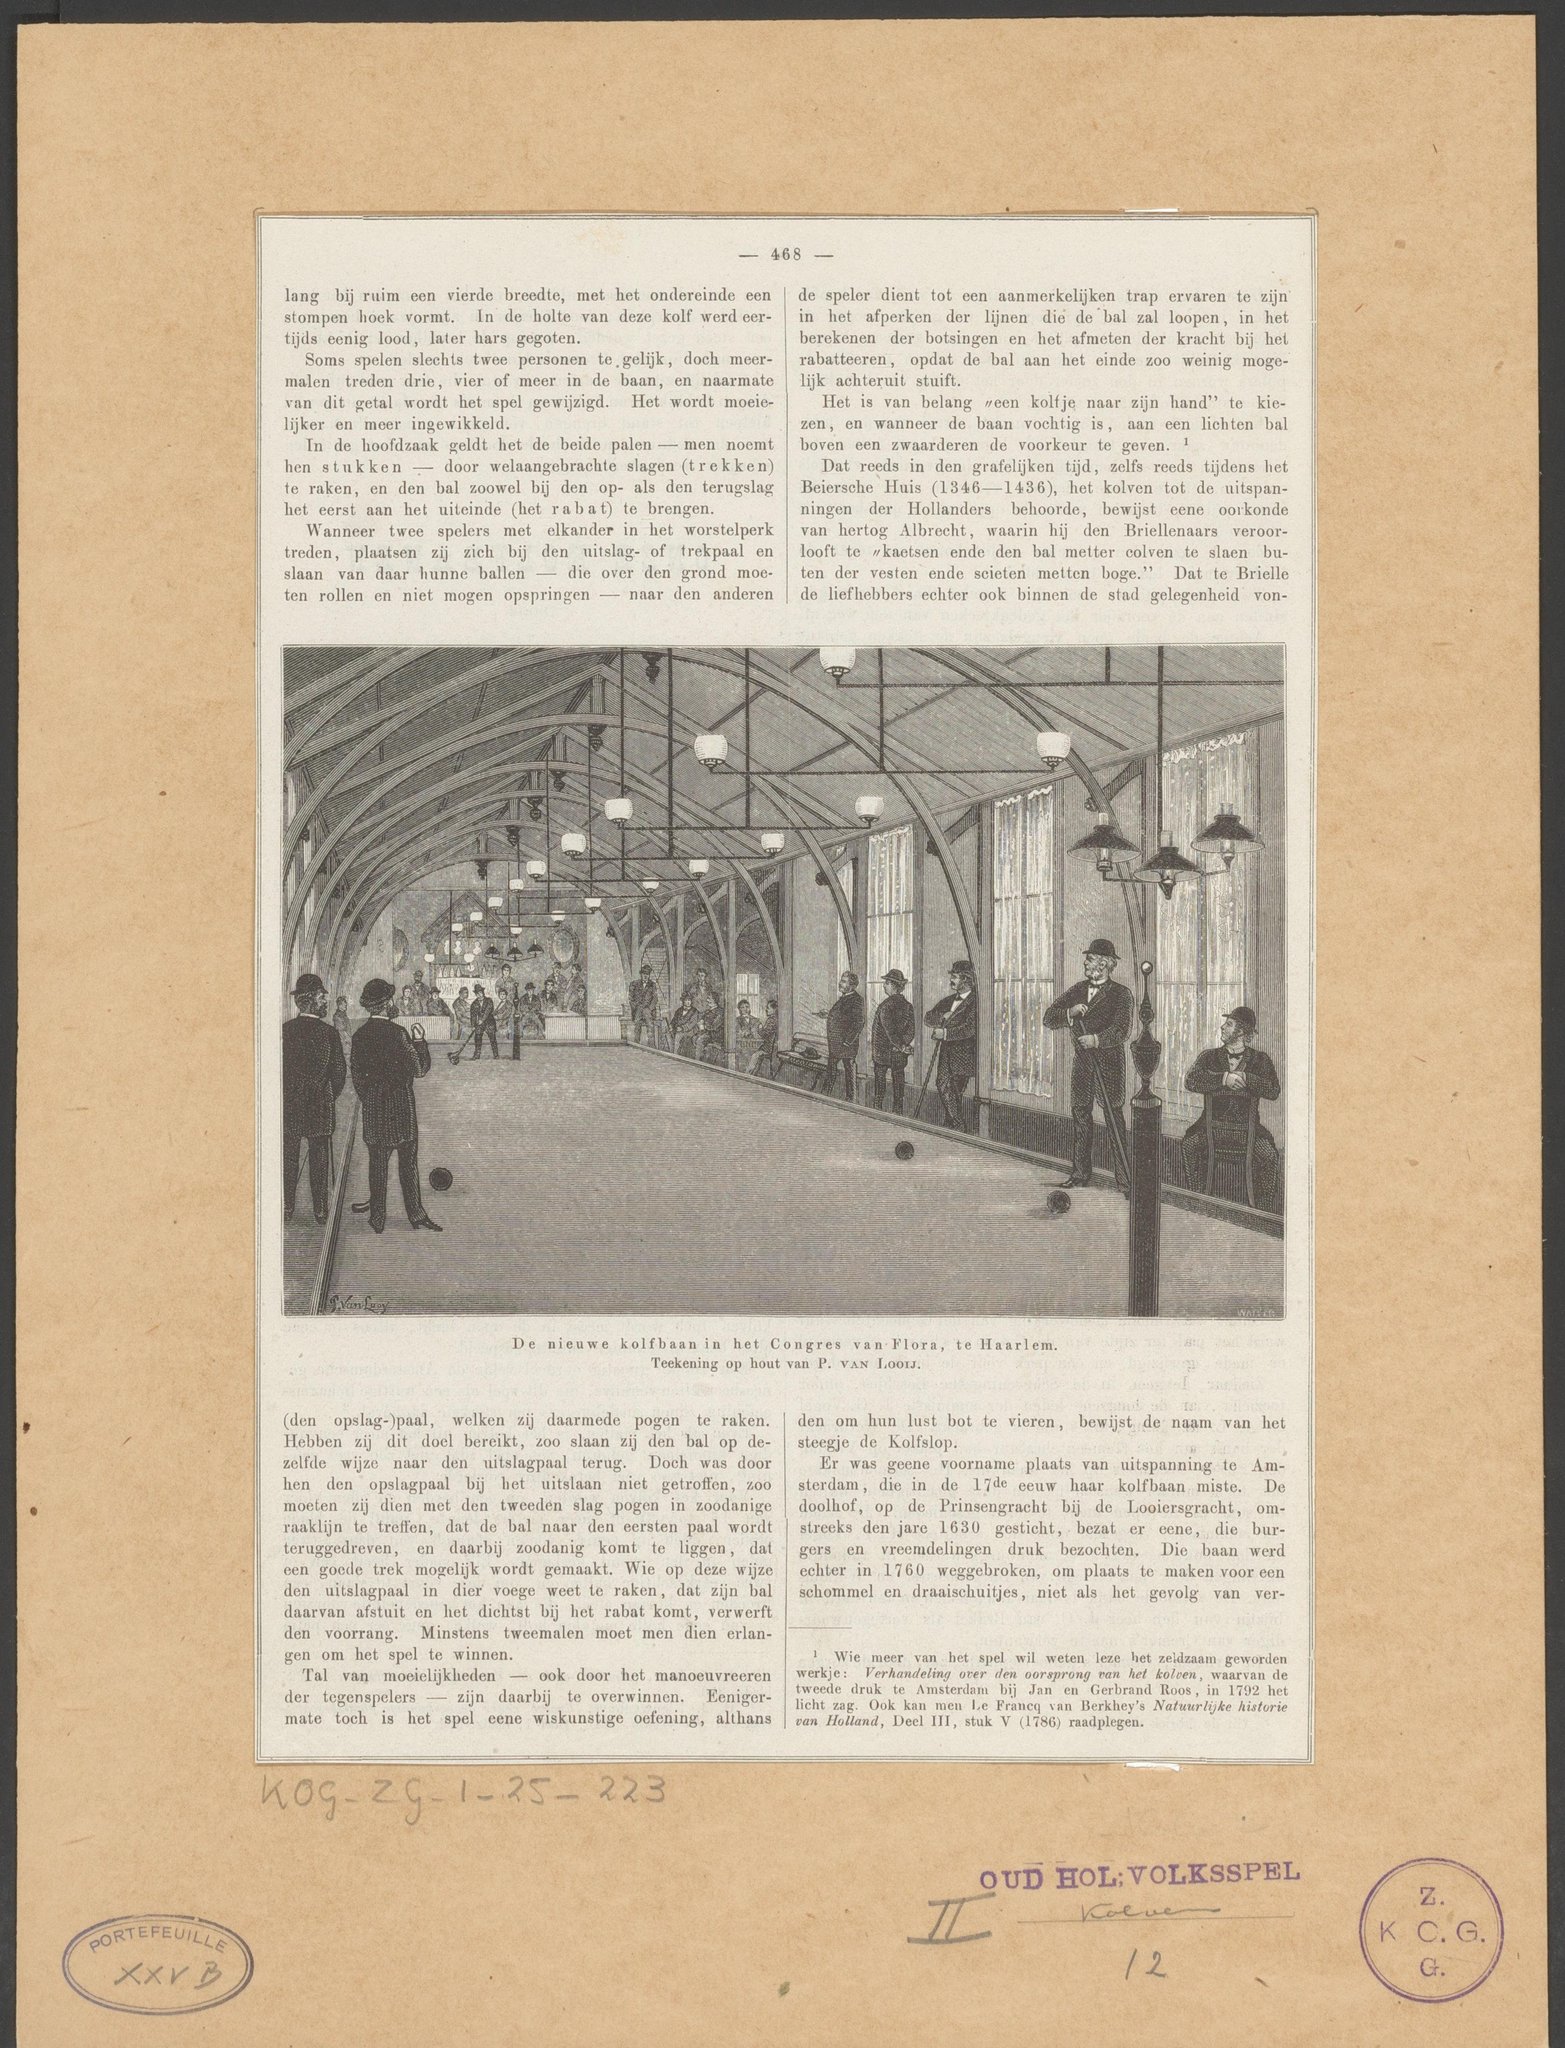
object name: print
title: De nieuwe kolfbaan in het Congres van Flora, te Haarlem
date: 1919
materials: paper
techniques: letterpress printing, engraving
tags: 'kolf' (ball game), haarlem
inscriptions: collector's mark: Lugt 1641, stamp, stamp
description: Onderwerpsrubrieken binnen de Atlas Zeden en Gewoonten: Zeden en Gewoonten in Engeren Zin, Spel en vermaak, Oud-Hollandsch volksspel, Kolven.